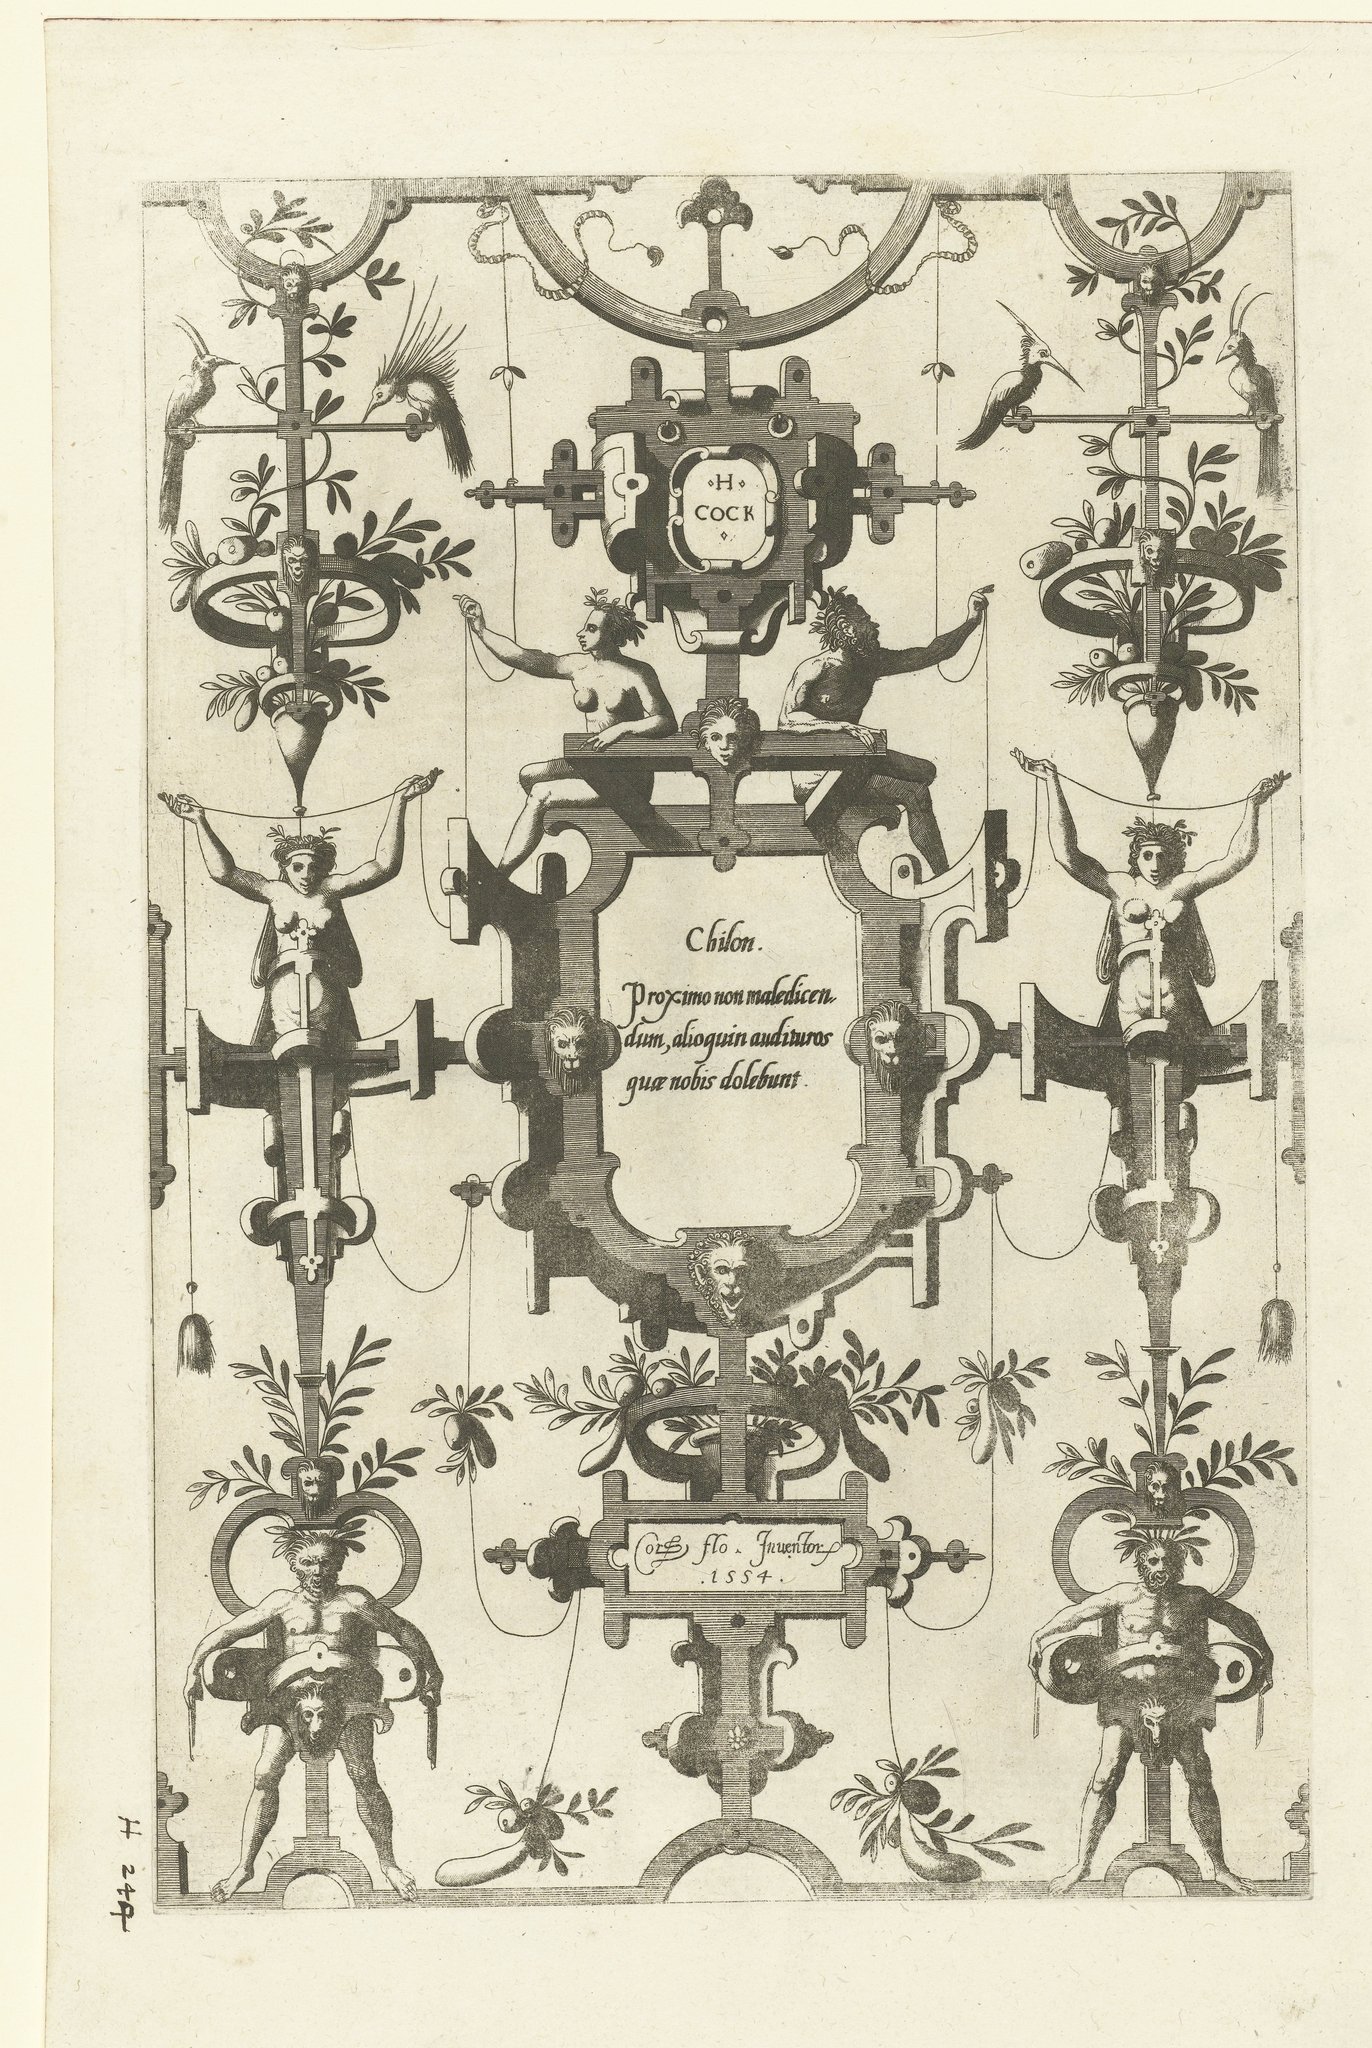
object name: ornament print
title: Vlakdecoraties: cartouches met citaten van filosofen in een omlijsting van rolwerk, grotesken, figuren, guirlandes en trofeeën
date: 1558-1630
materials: paper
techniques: etching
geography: netherlands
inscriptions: number: ‘H. 244’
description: Cartouche met tekst van Chilo tussen twee kandelabers, opgebouwd uit rolwerk met een sater, een herme en een vaas met bloemen. Hoort bij serie van 6 bladen.